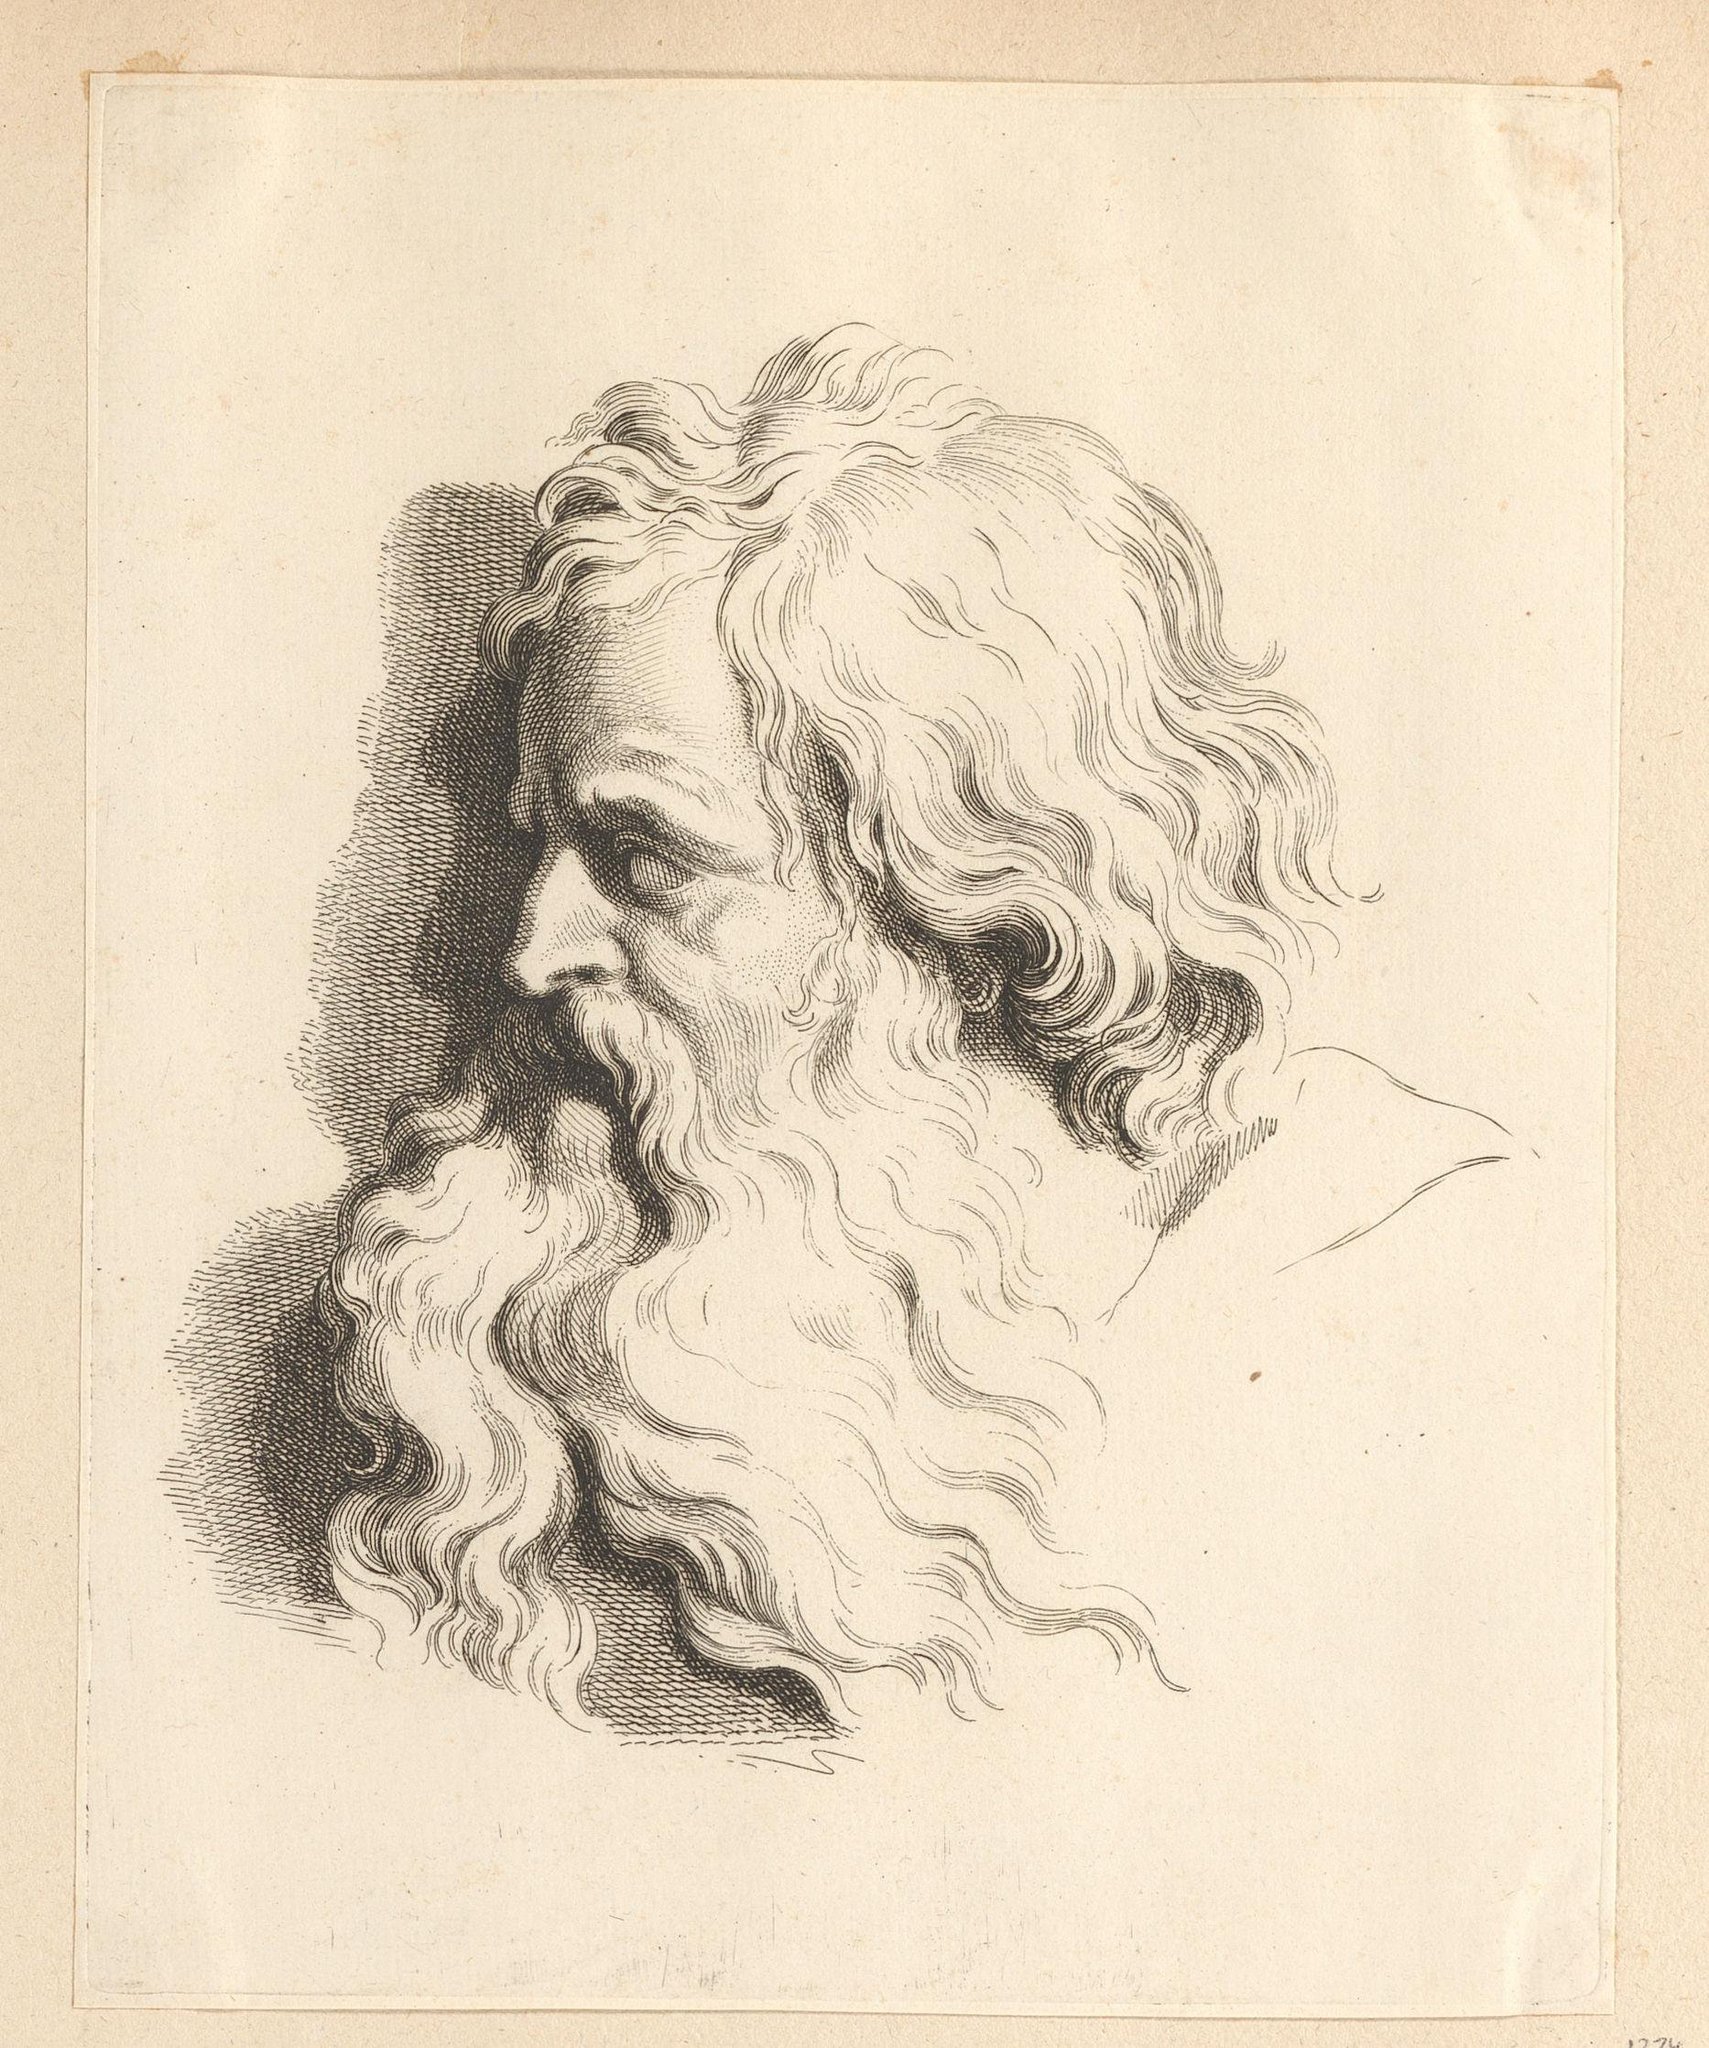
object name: print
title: Hoofd van een oude man met baard, en profil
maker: sébastien leclerc (i)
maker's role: print maker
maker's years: 1637-1714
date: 1647-1714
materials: paper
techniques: engraving, etching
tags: old man, beard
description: Maakt volgens IFF 17e siècle deel uit van een serie met modellen van gezichten, bedoeld voor tekenstudenten.